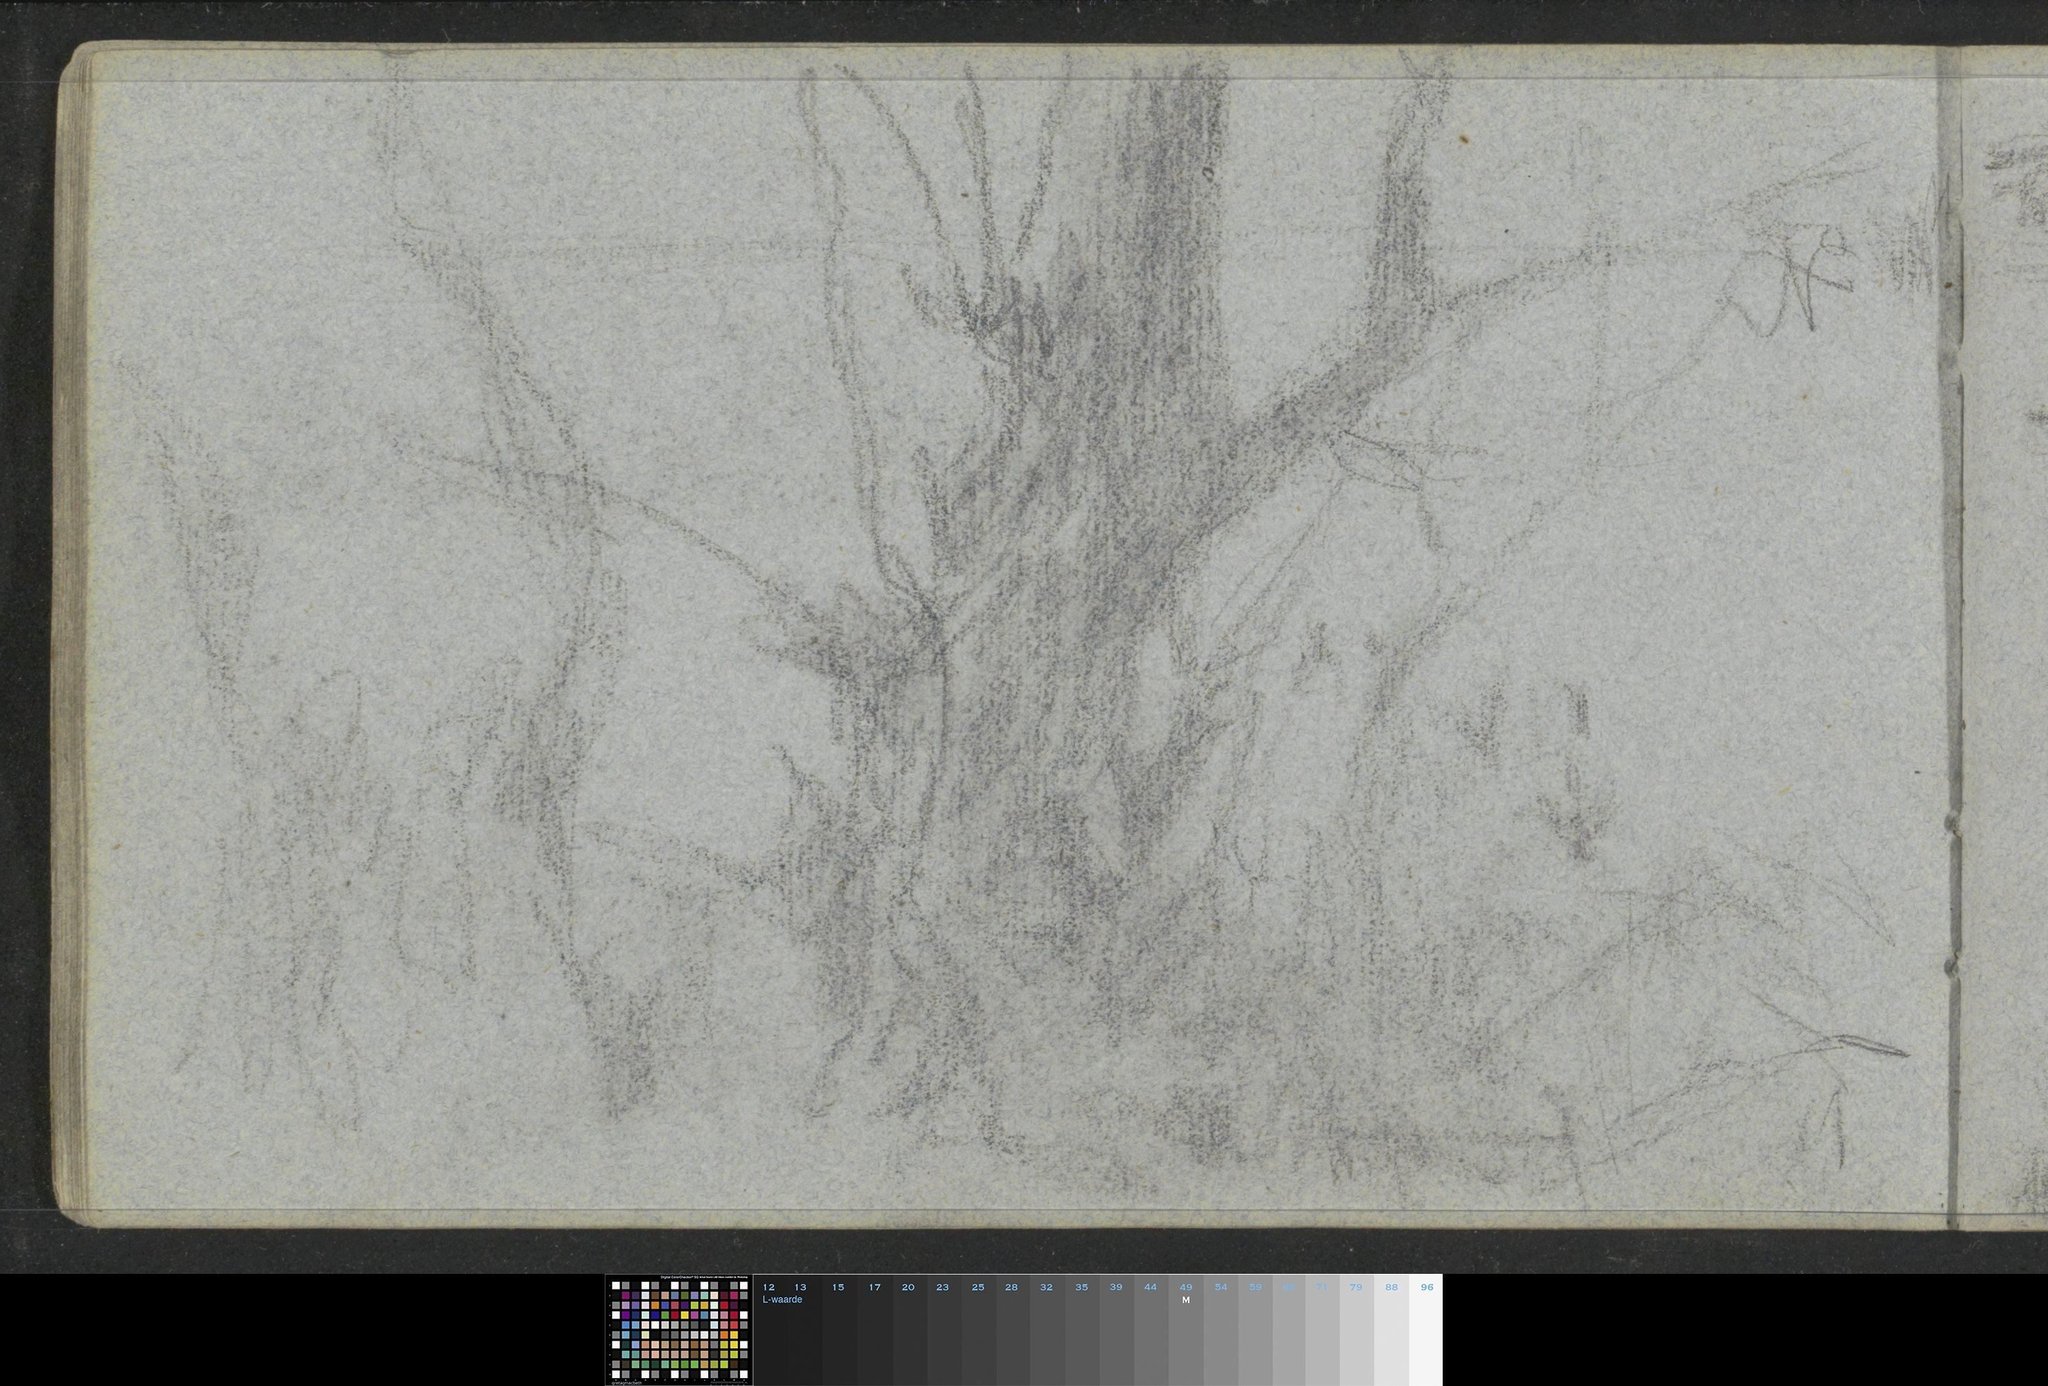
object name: sketchbook leaf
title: Boom en struiken aan een waterkant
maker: matthijs maris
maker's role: draughtsman, painter, print maker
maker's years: 1839-1917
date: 1849-1917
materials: paper, pencil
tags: trees, shrubs, landscapes with waters, waterscapes, seascapes (in the temperate zone)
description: Blad 9 verso uit een schetsboek met 35 bladen.